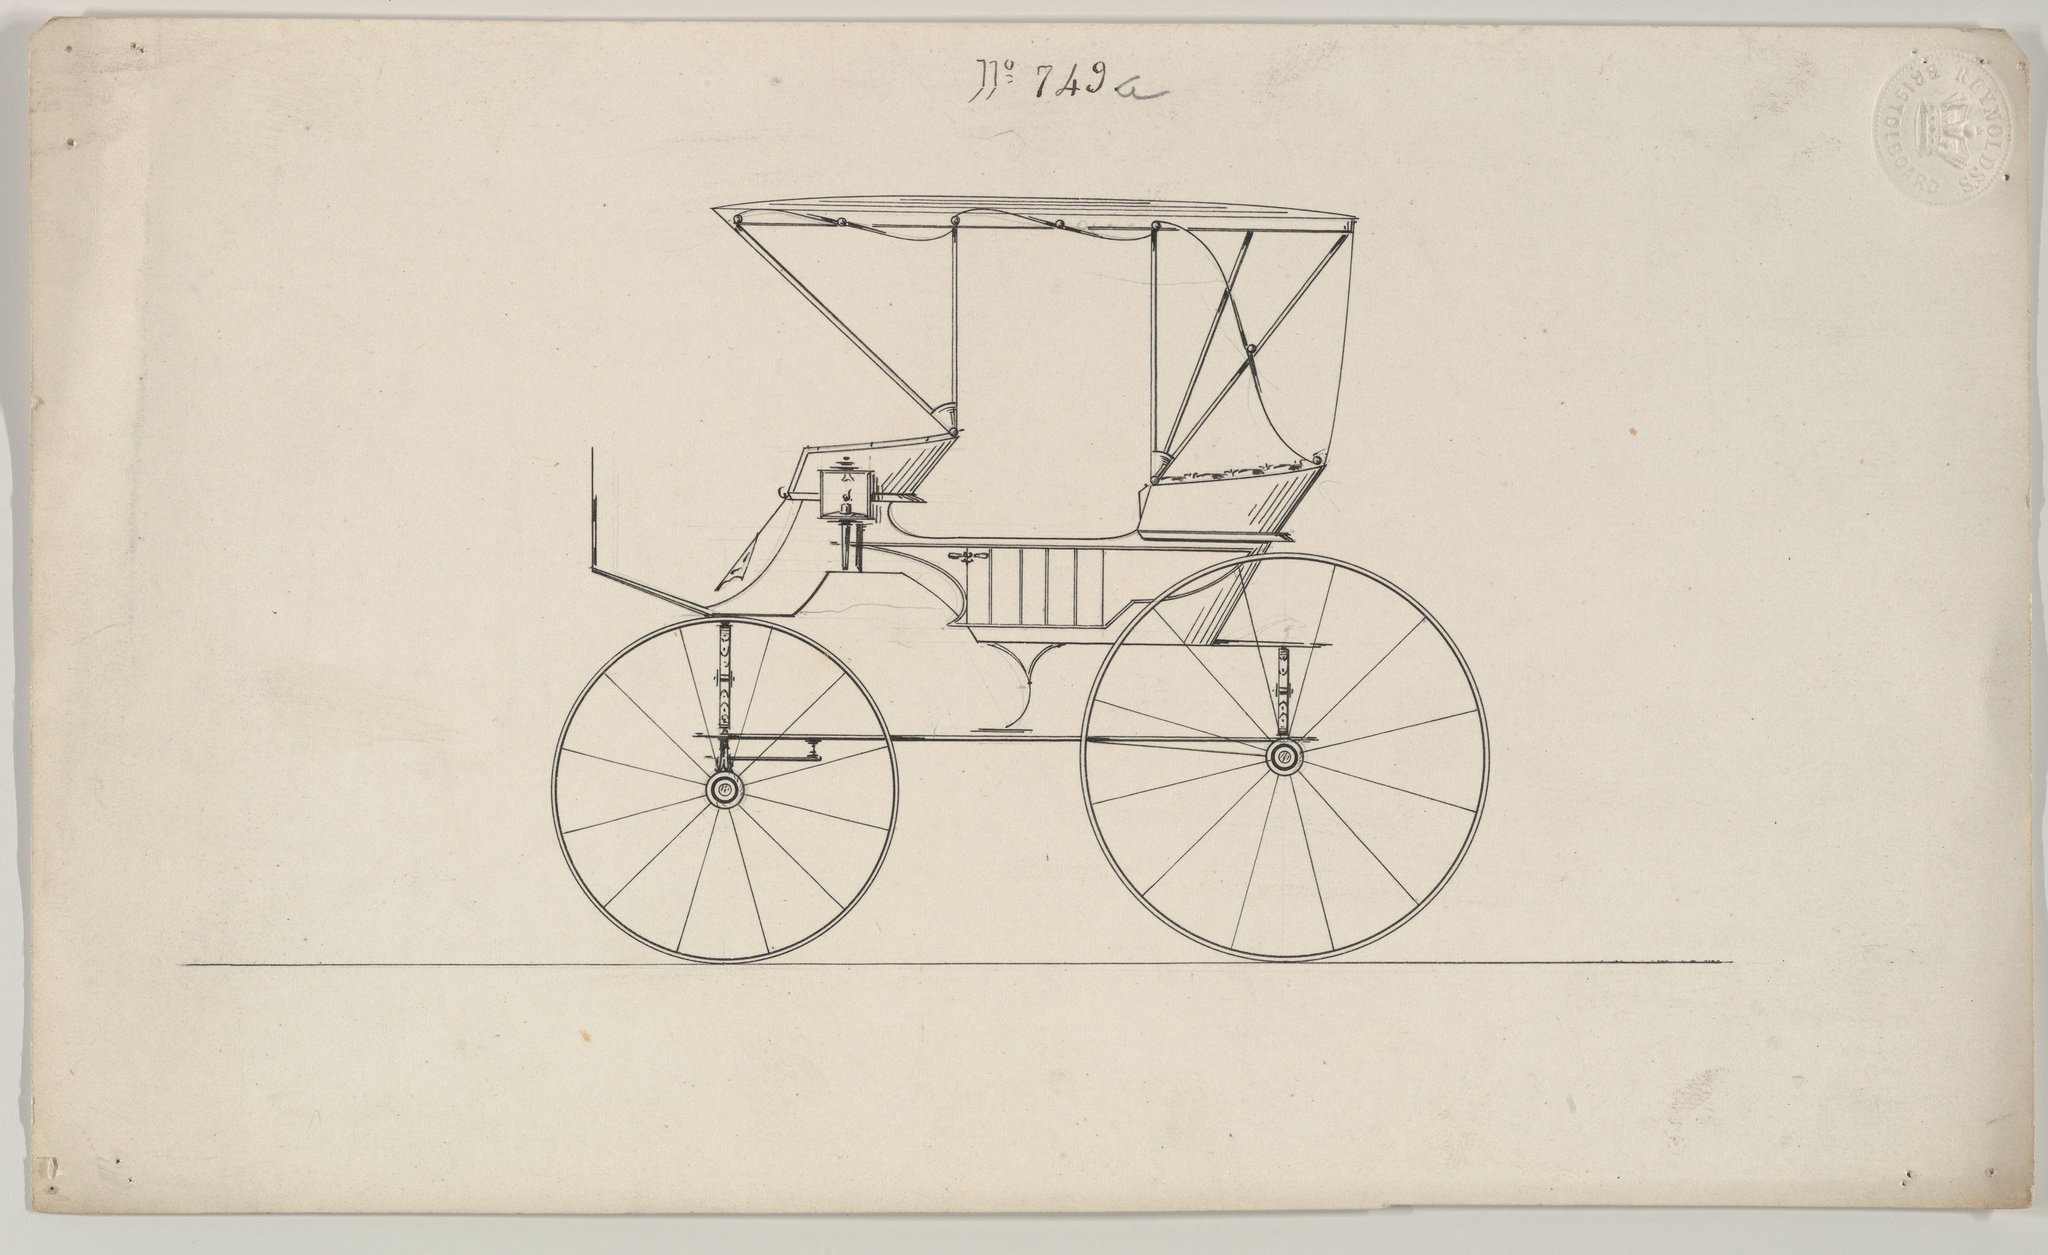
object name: drawing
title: Design for Park Phaeton, no. 749a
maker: brewster & co.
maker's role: manufacturer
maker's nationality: american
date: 1850-1874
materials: ink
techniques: pen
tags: carriages